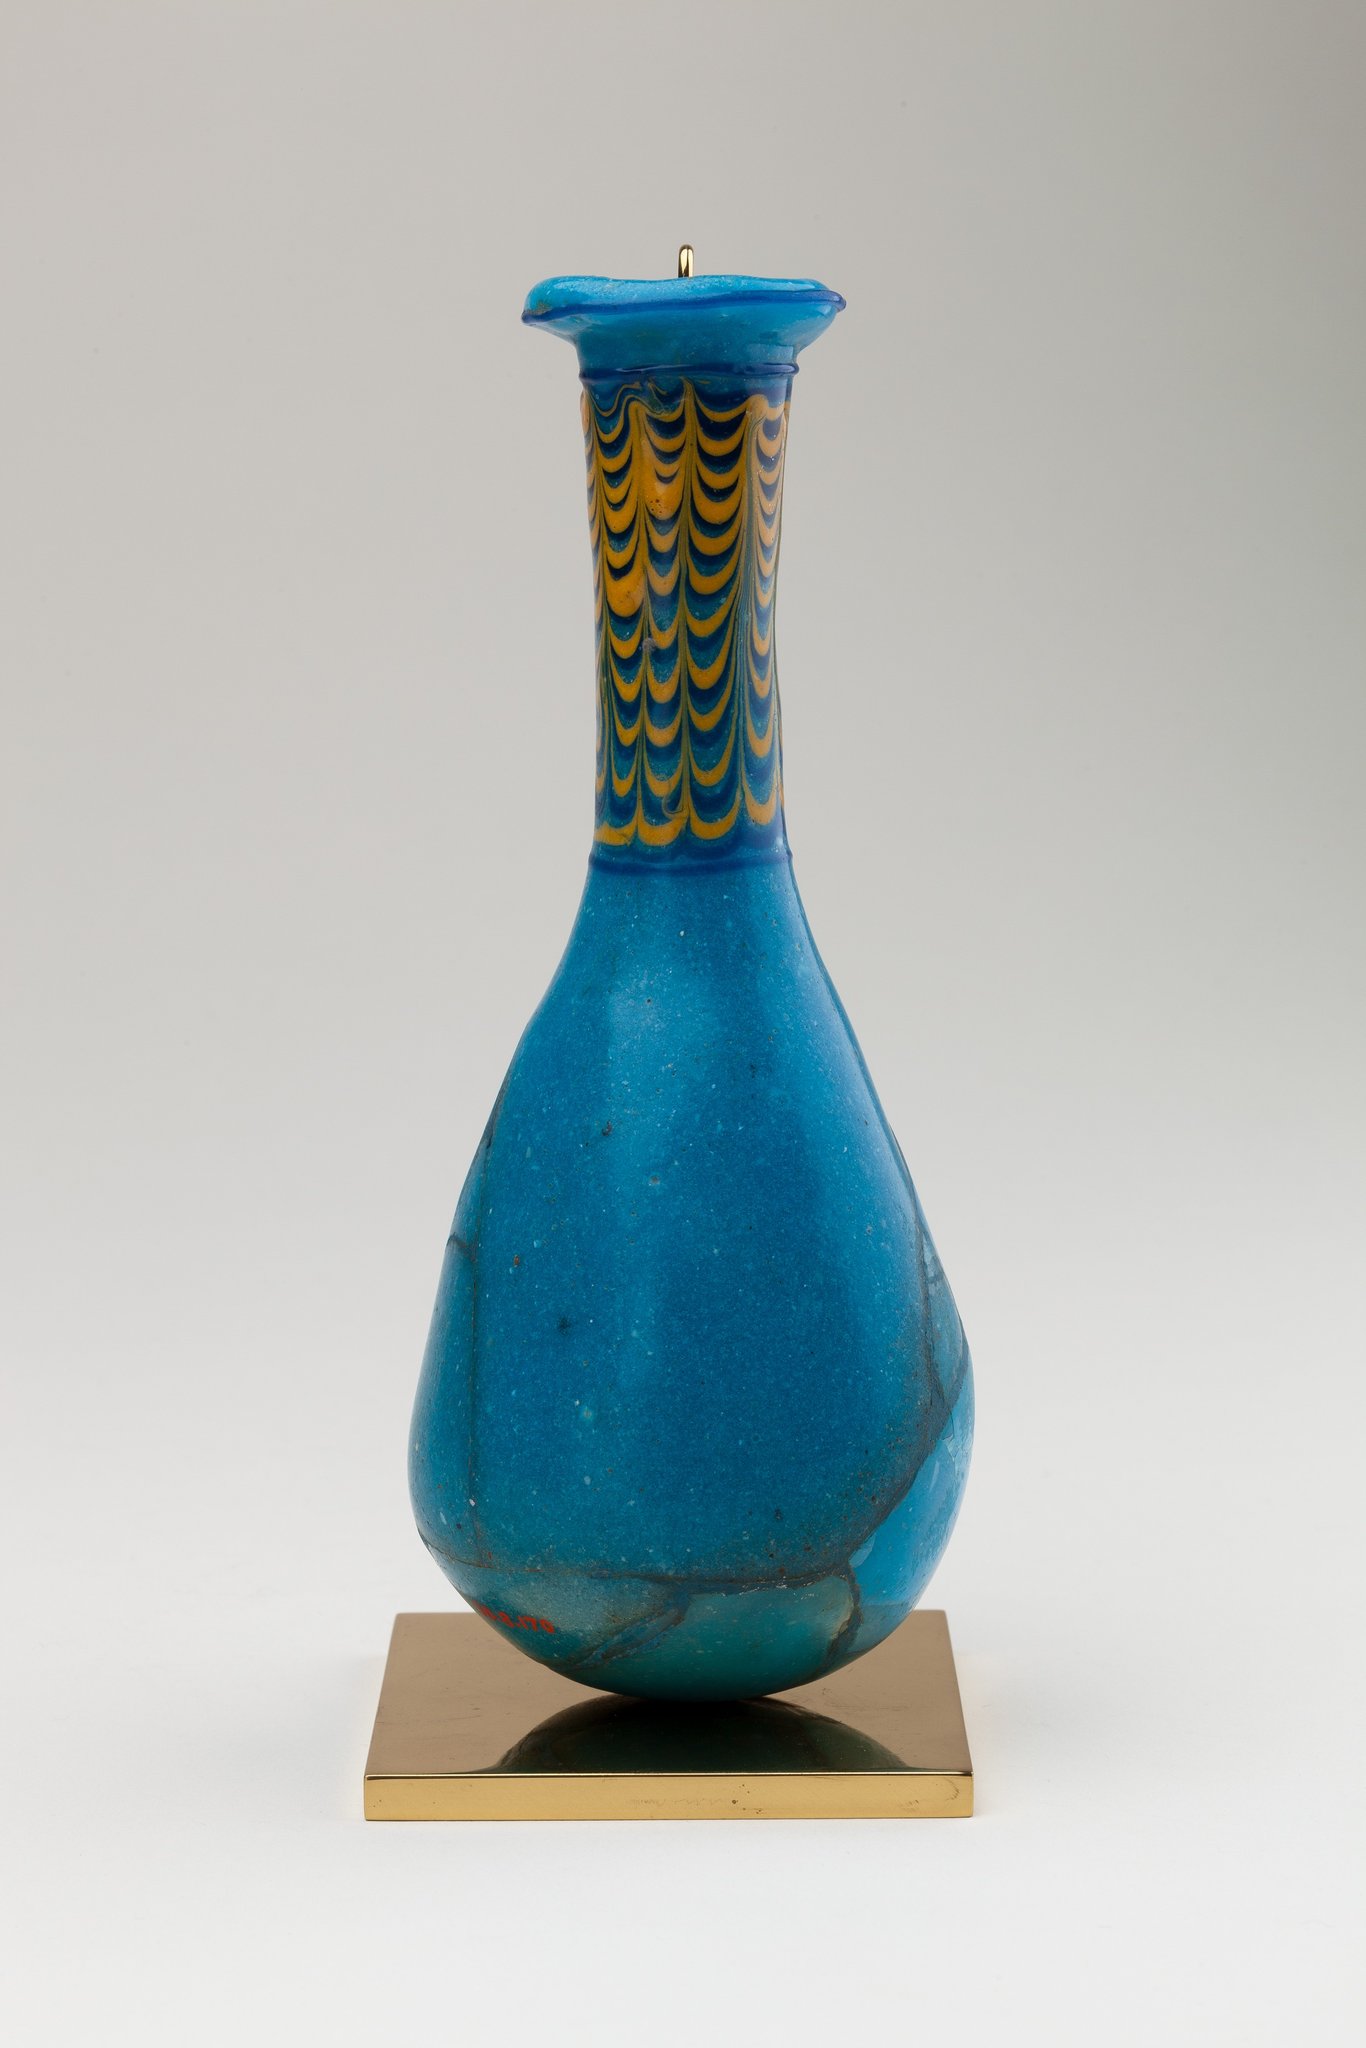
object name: bottle, polychrome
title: Bottle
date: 1295-1070 BCE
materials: glass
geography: egypt